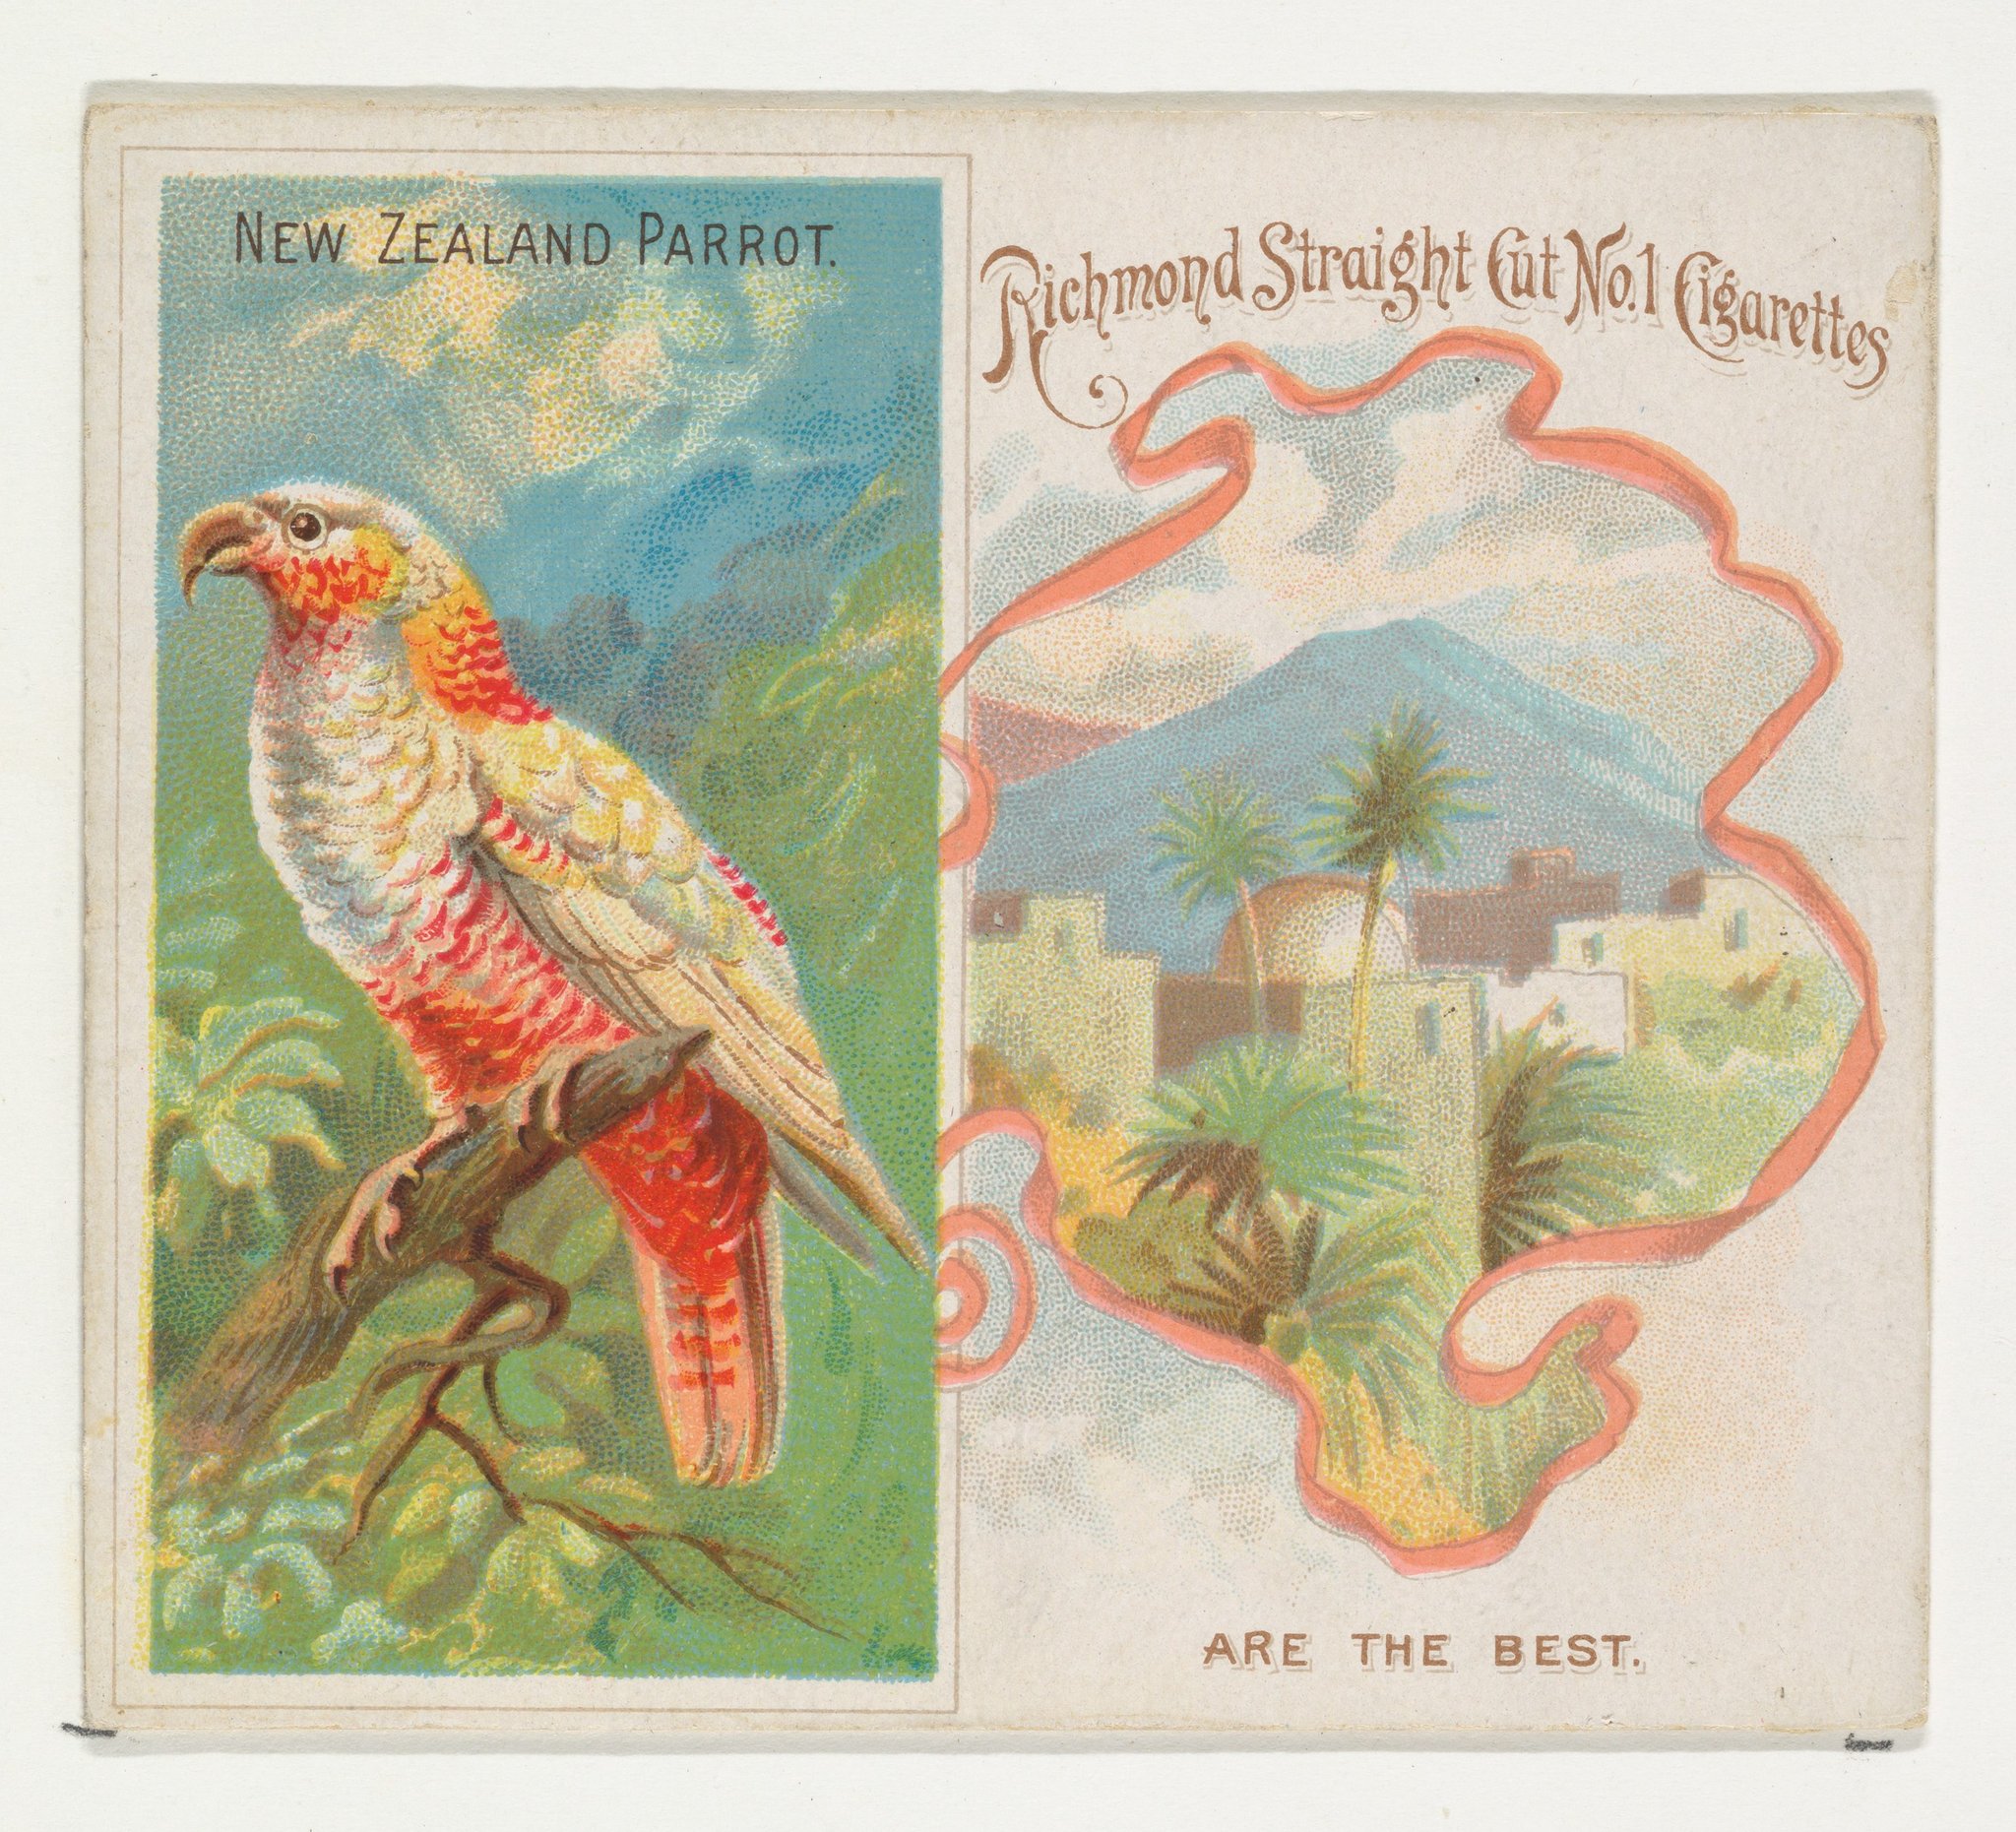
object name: print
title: New Zealand Parrot, from Birds of the Tropics series (N38) for Allen & Ginter Cigarettes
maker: allen & ginter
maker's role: publisher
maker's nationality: american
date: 1889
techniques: color lithograph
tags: parrots